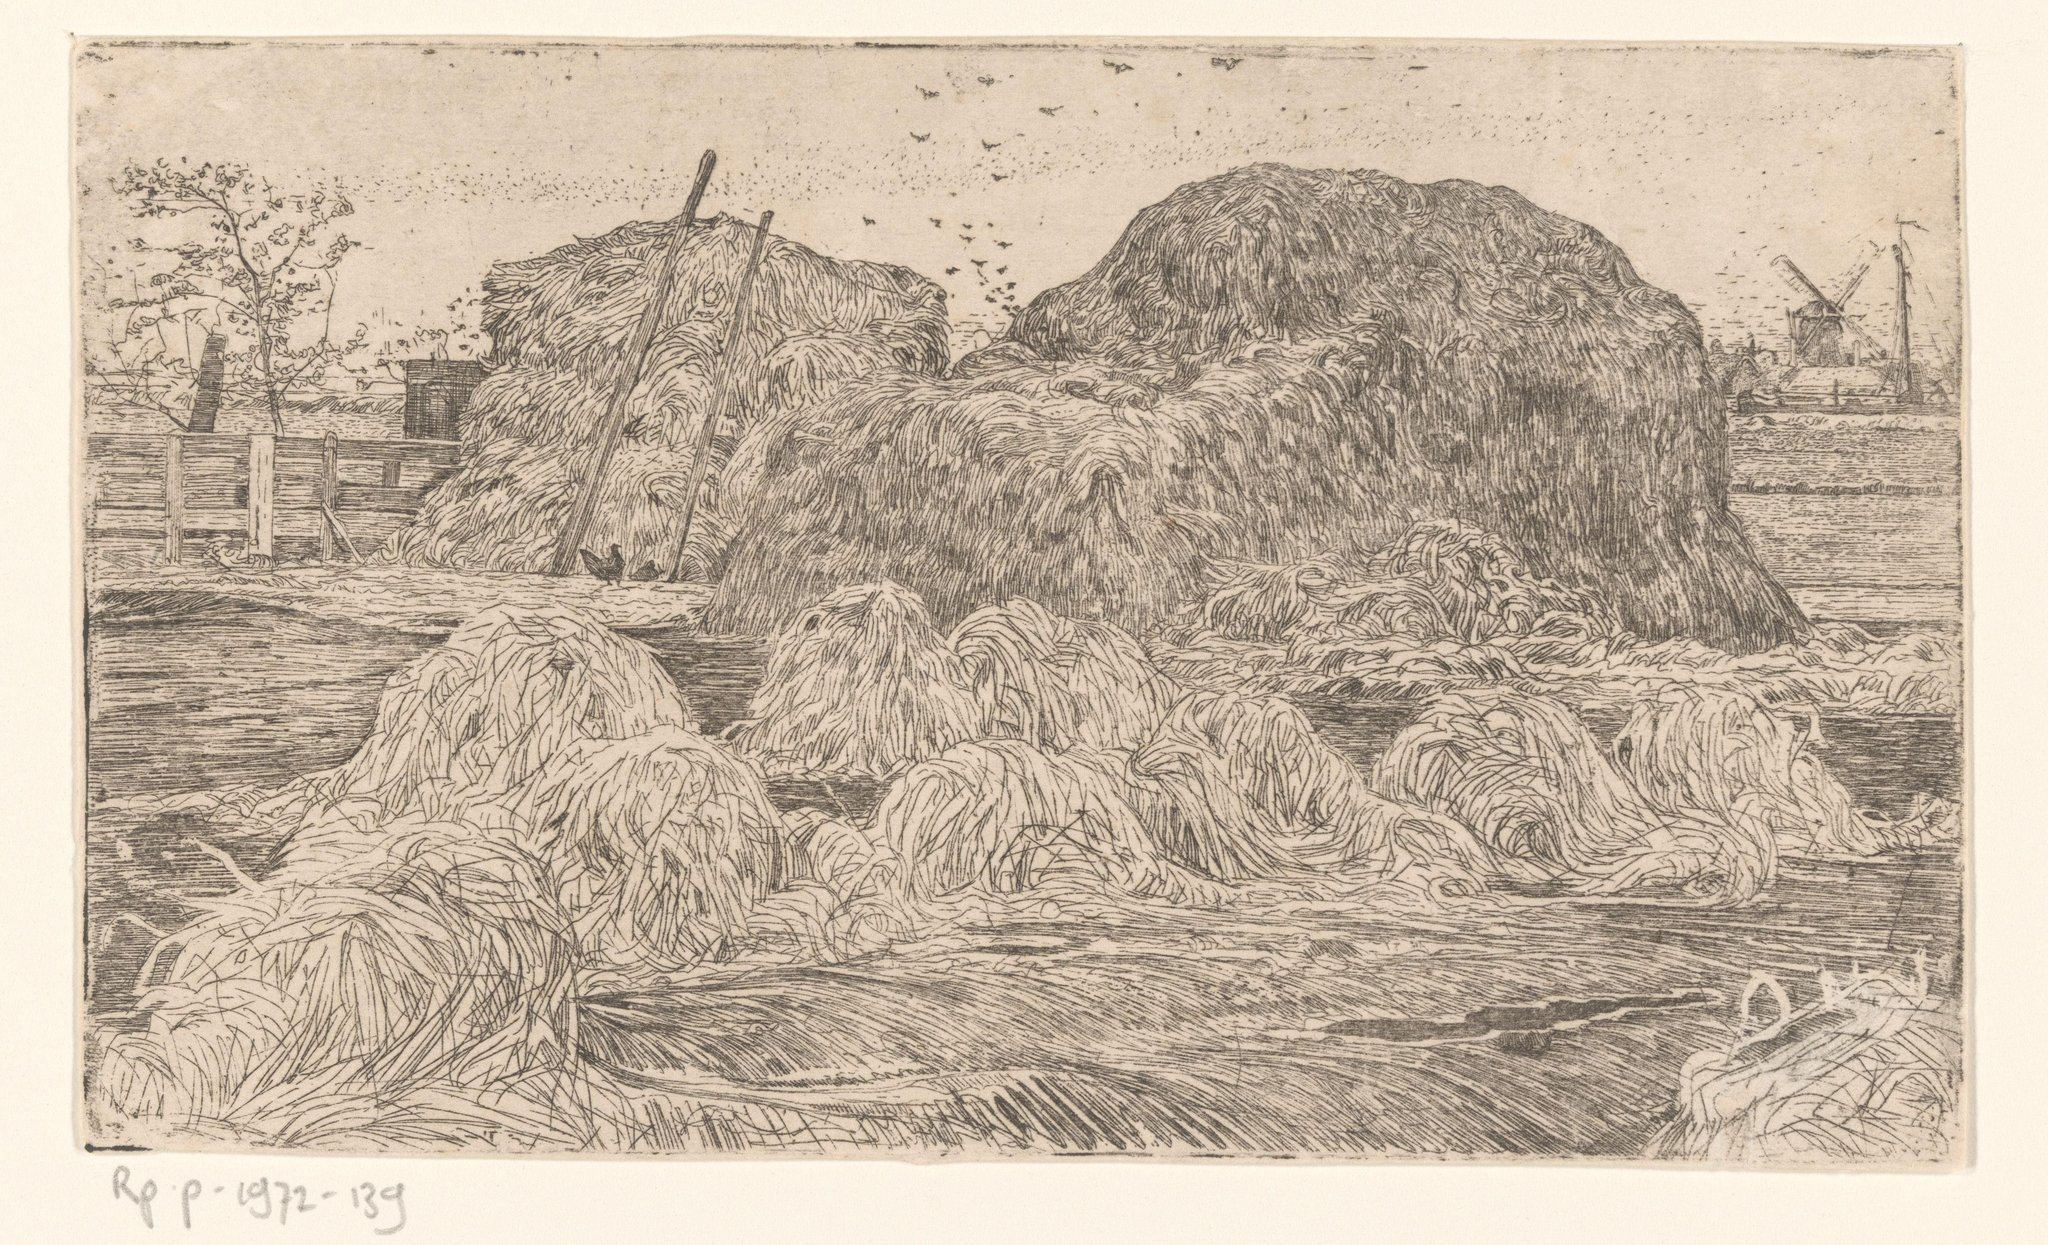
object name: print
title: Hooibaal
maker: maurits van der valk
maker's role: draughtsman, print maker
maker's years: 1857-1935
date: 1867-1935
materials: paper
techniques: etching, intaglio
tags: hay-stack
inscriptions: collector's mark: Lugt 2760, collector's mark: Lugt 2228